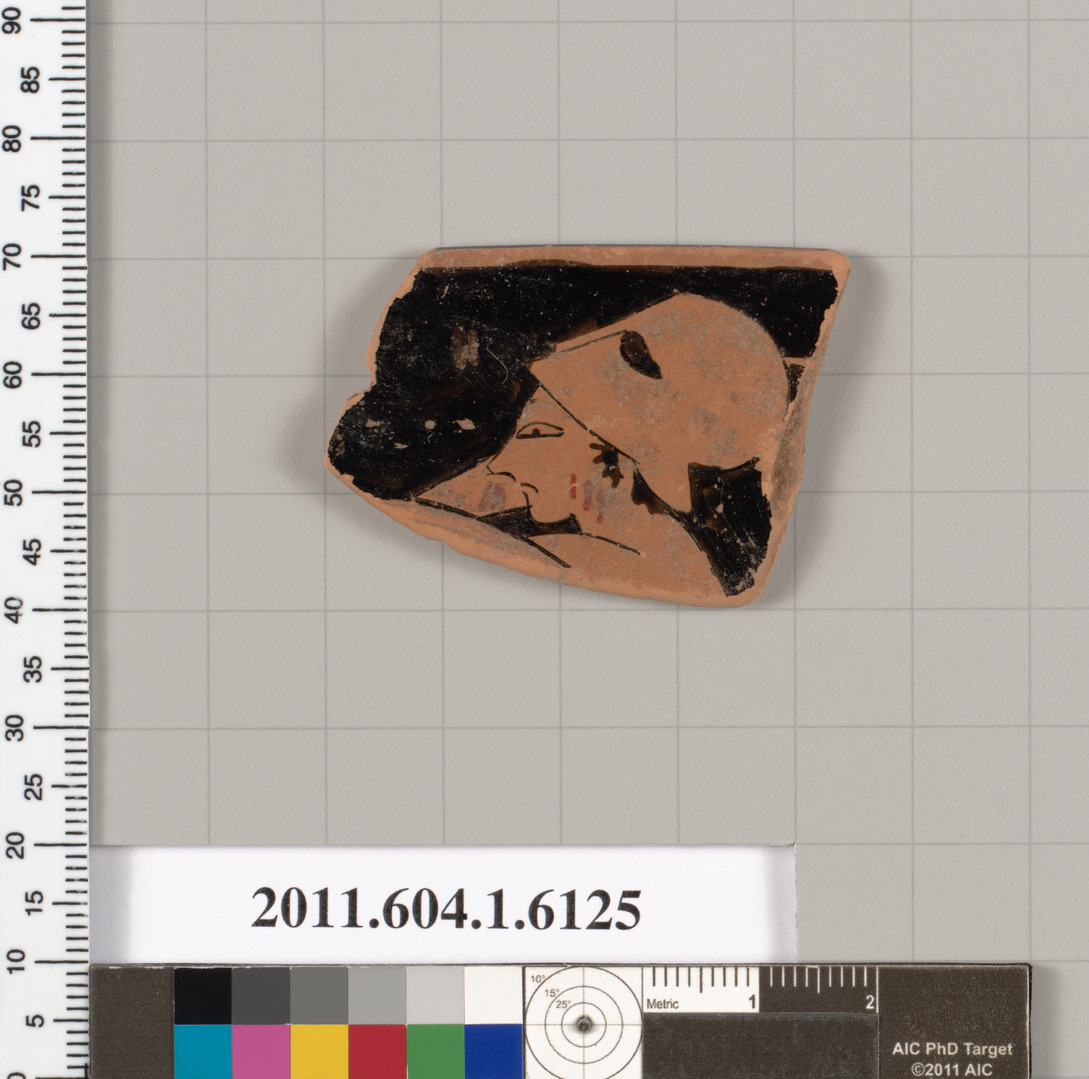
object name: kylix fragment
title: Terracotta rim fragment of a kylix (drinking cup)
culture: greek, attic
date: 520-500 BCE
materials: terracotta